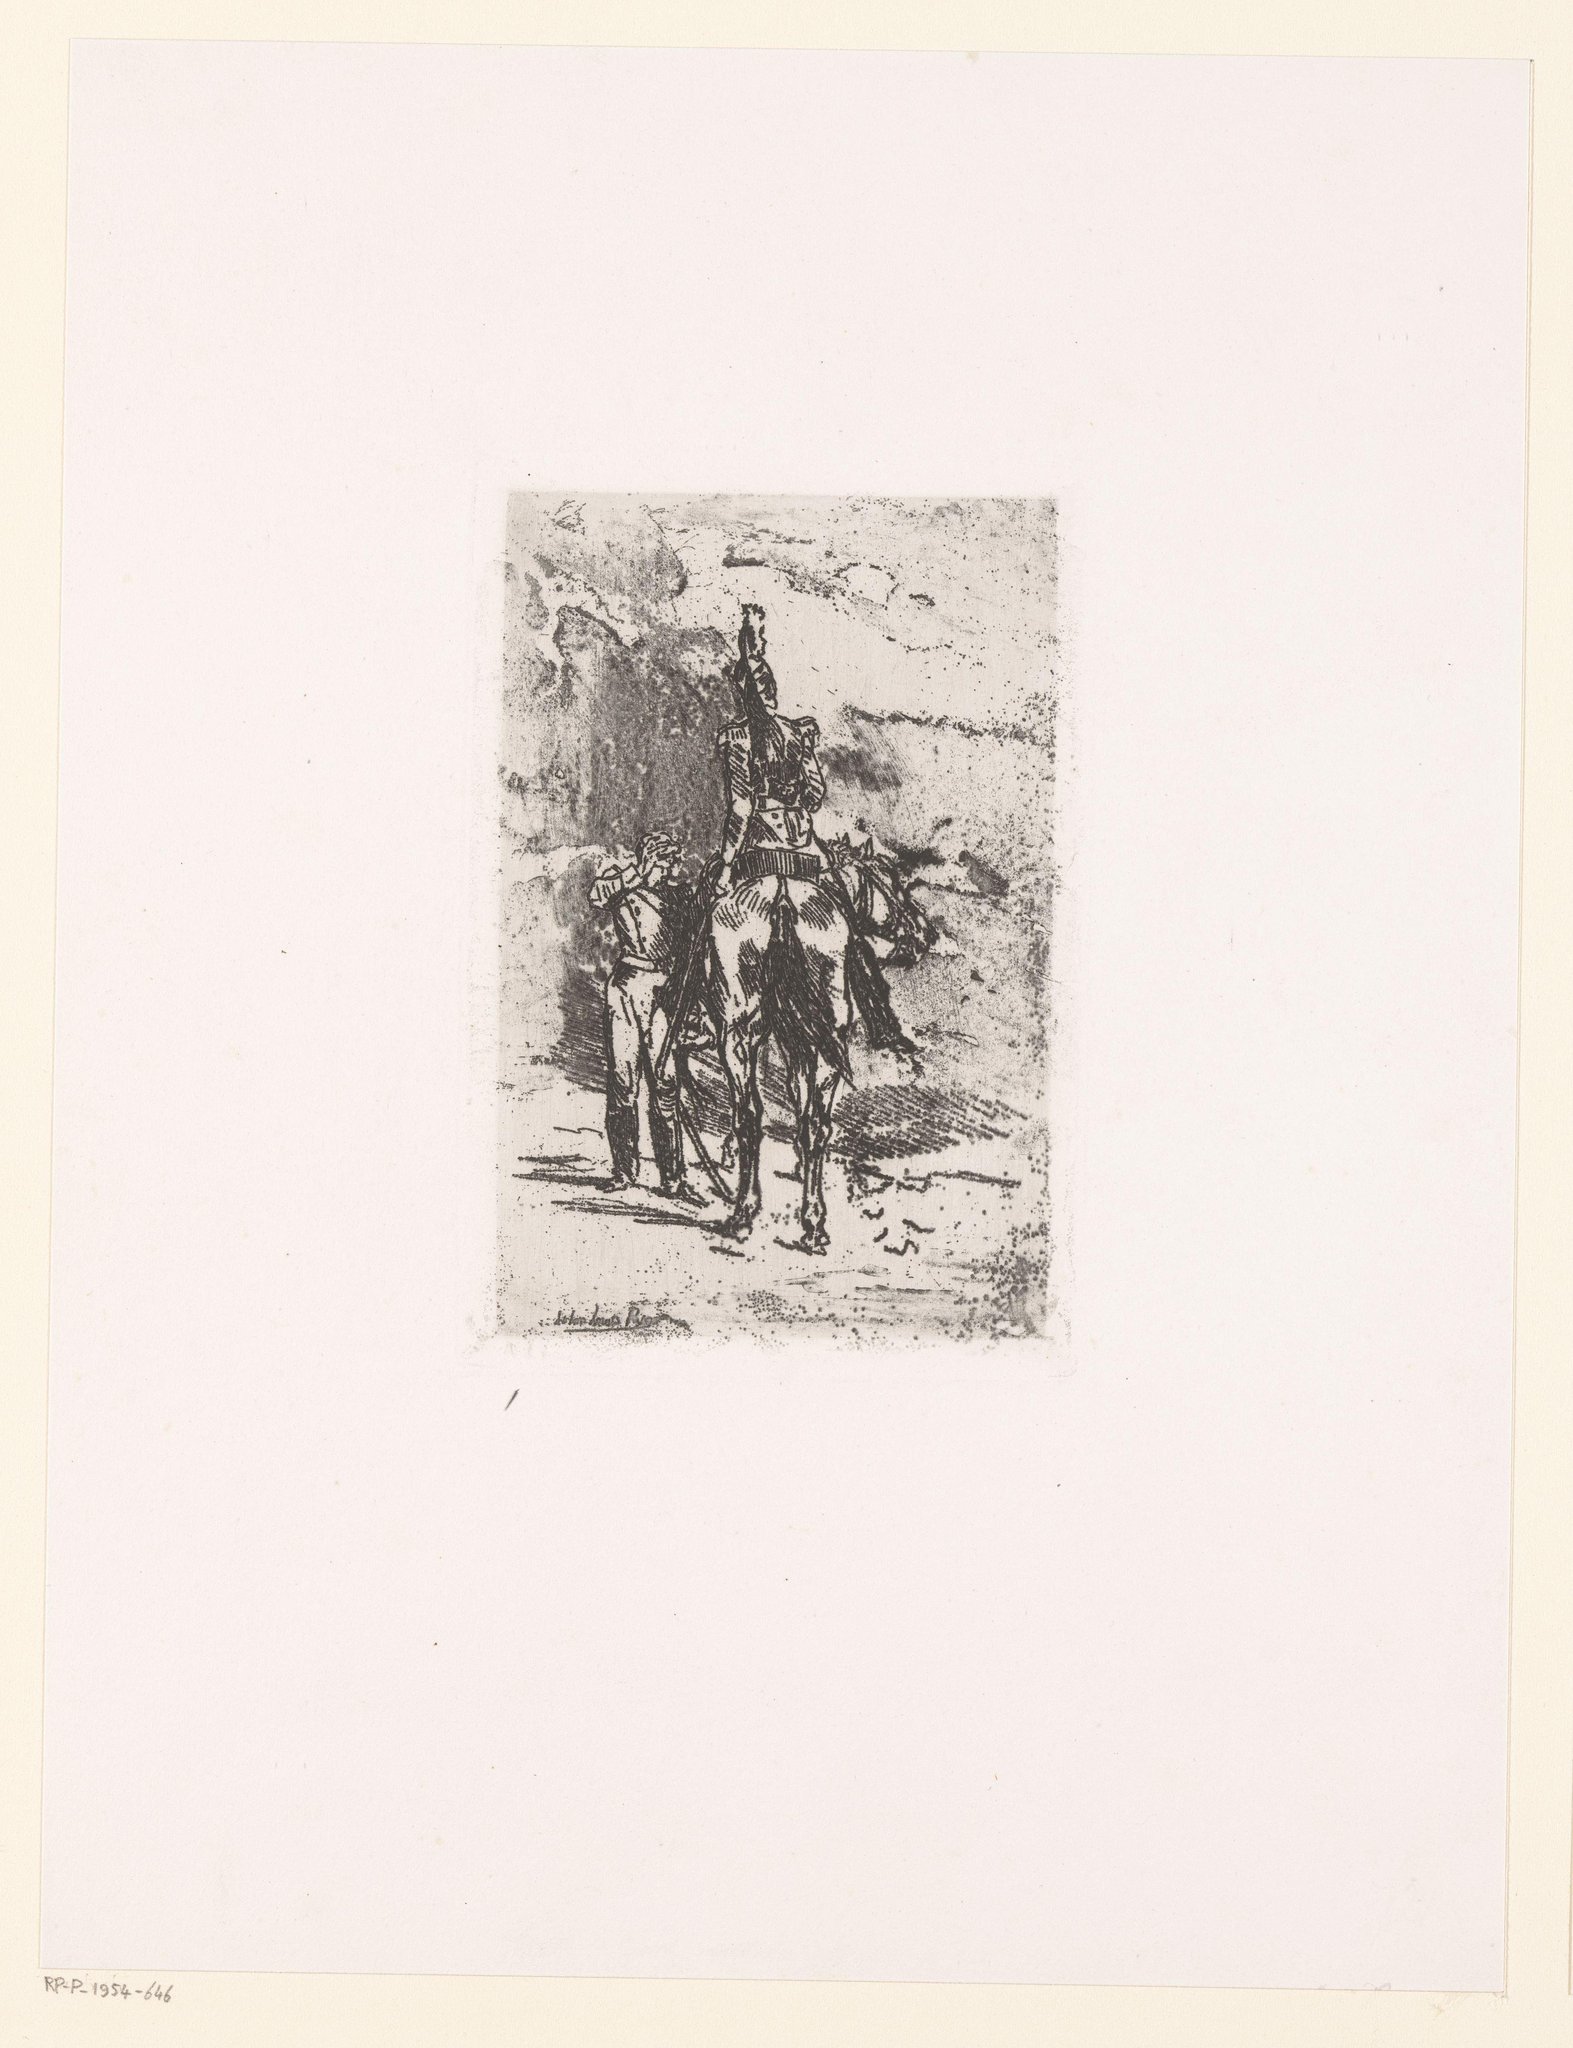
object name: print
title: Huzaar te paard in gesprek met een officier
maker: john lewis brown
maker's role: print maker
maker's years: 1829-1890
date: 1839-1890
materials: paper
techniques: aquatint, etching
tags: private soldier, officer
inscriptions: collector's mark: Lugt 2228, collector's mark: Lugt 2760